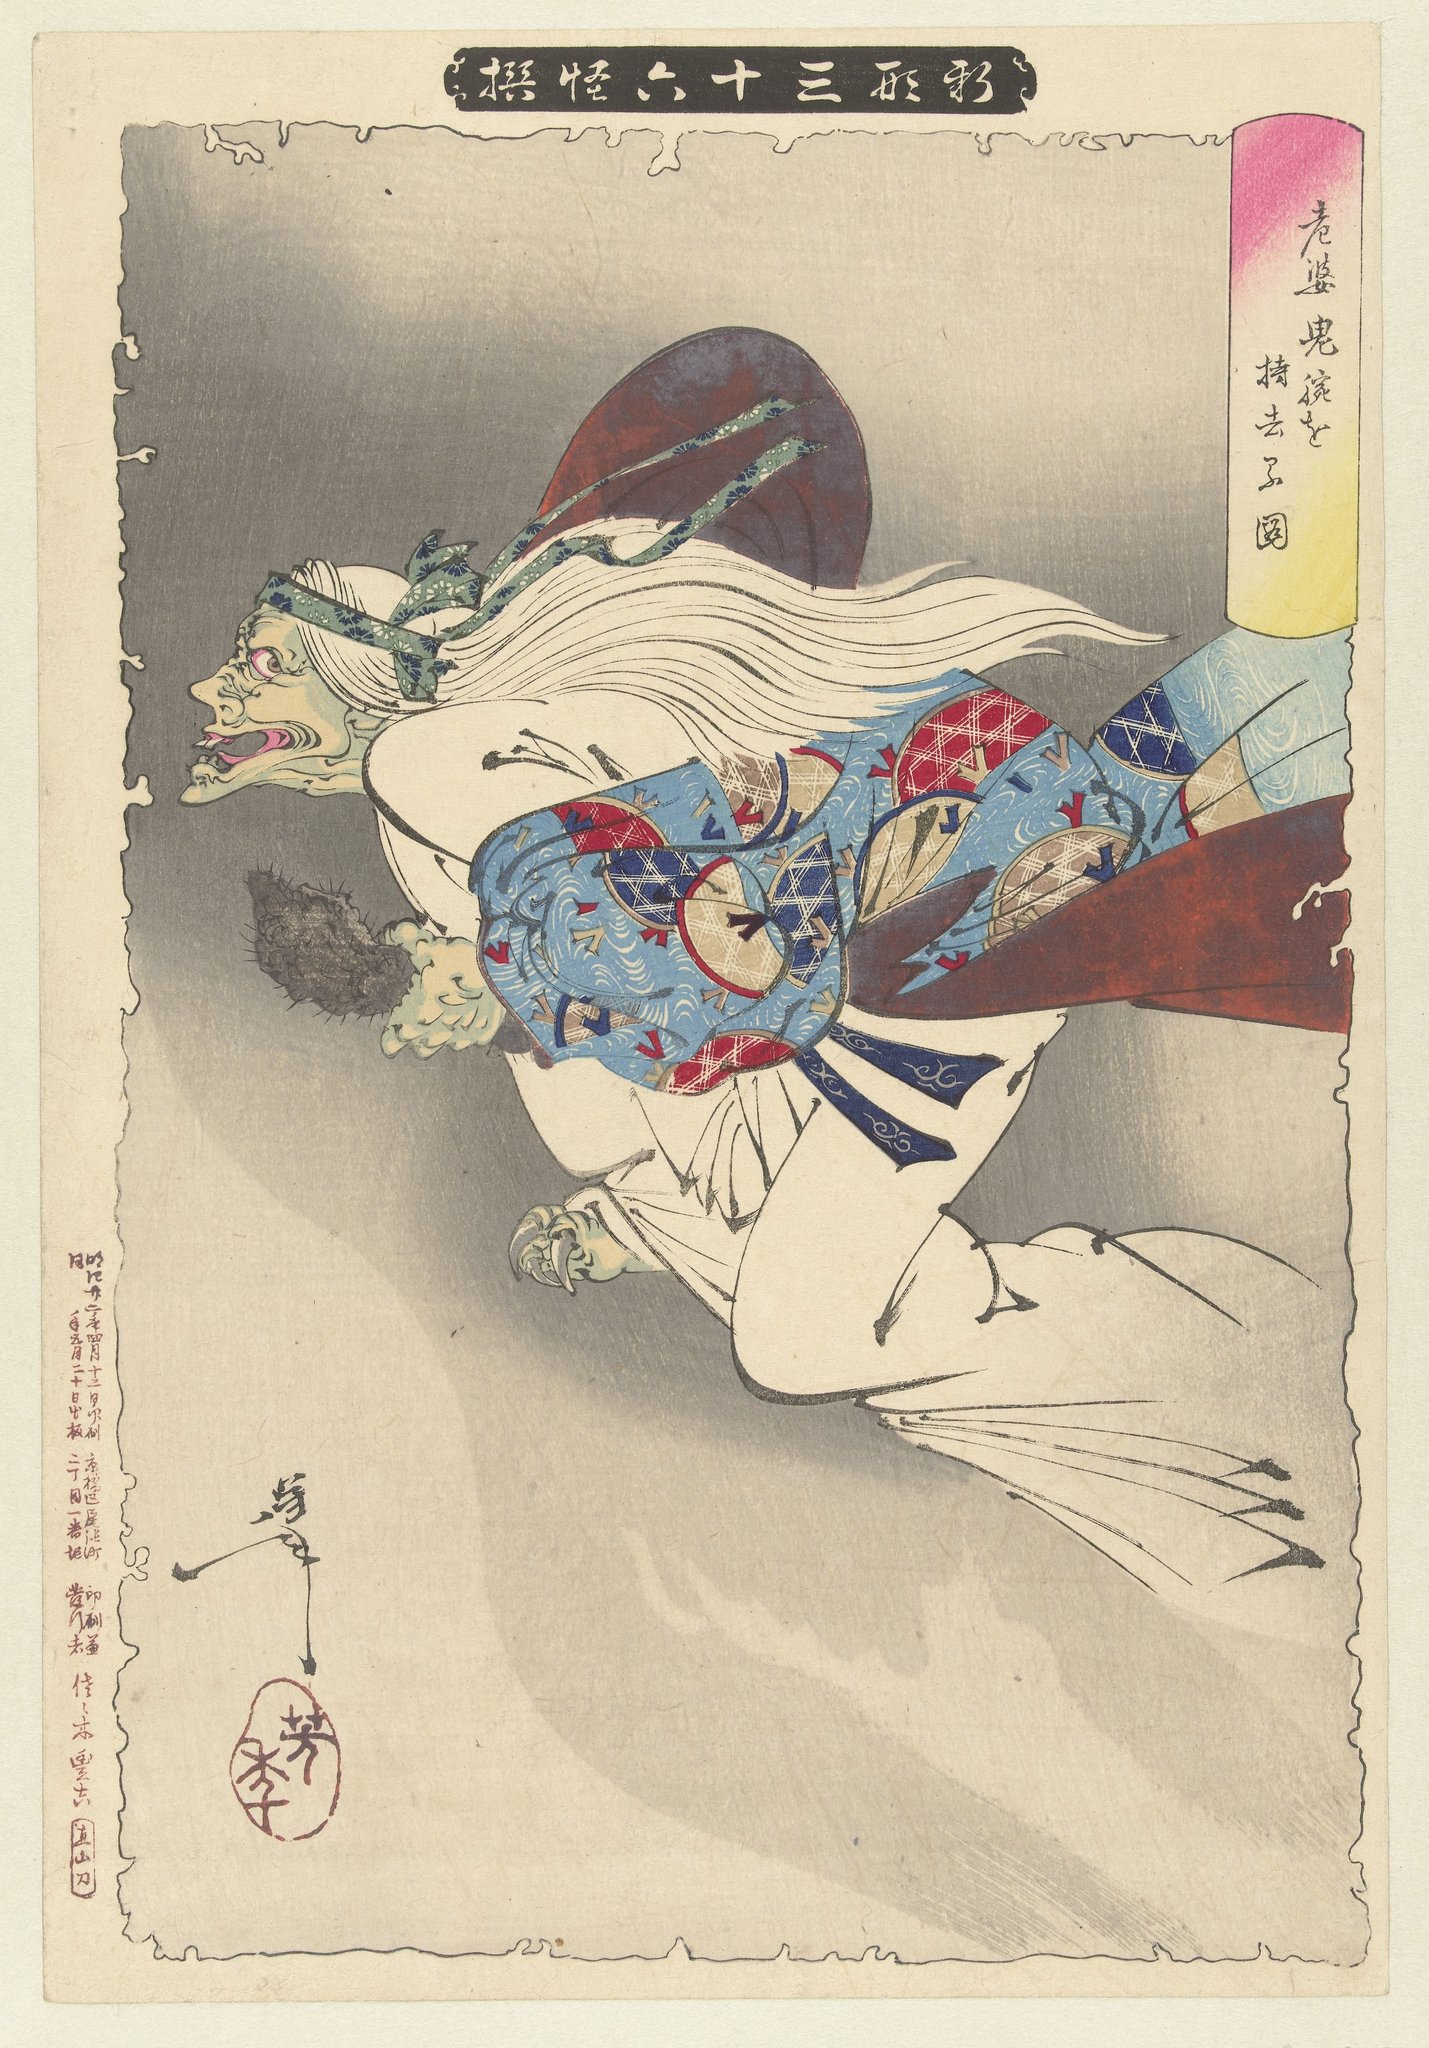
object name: print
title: Shinkei sanjurokkaisen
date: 1889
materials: paper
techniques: blind stamped, woodcut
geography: japan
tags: flying on or with the aid of object(s), old woman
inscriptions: collector's mark: Lugt 2228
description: Demon Ibaraki in de verschijning van een oude vrouw, rooft zijn arm, die in een nachtelijk gevecht door de krijger Watanabe no Tsuna was afgehakt, terug.